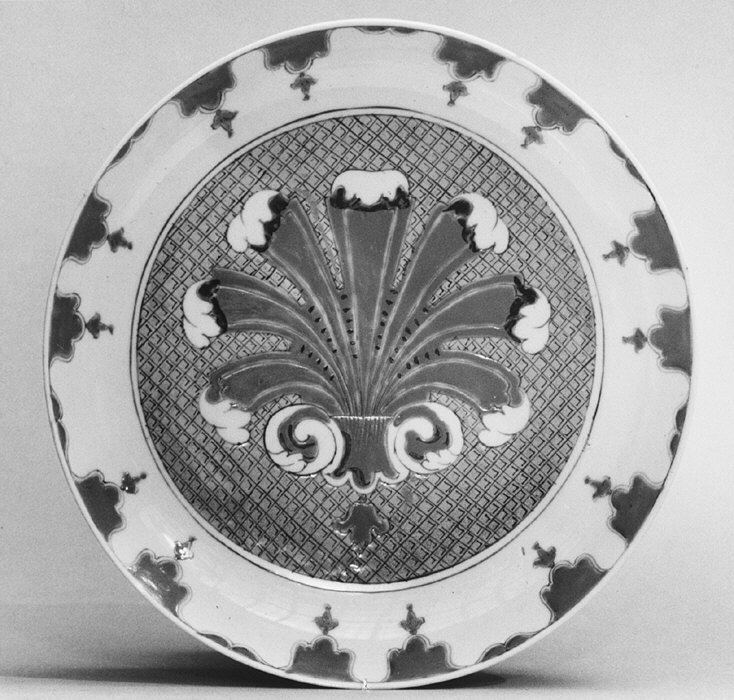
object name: dish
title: Dish (part of a service)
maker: cornelis pronk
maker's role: artist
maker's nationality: dutch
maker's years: 1691-1759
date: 1740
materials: hard paste porcelain